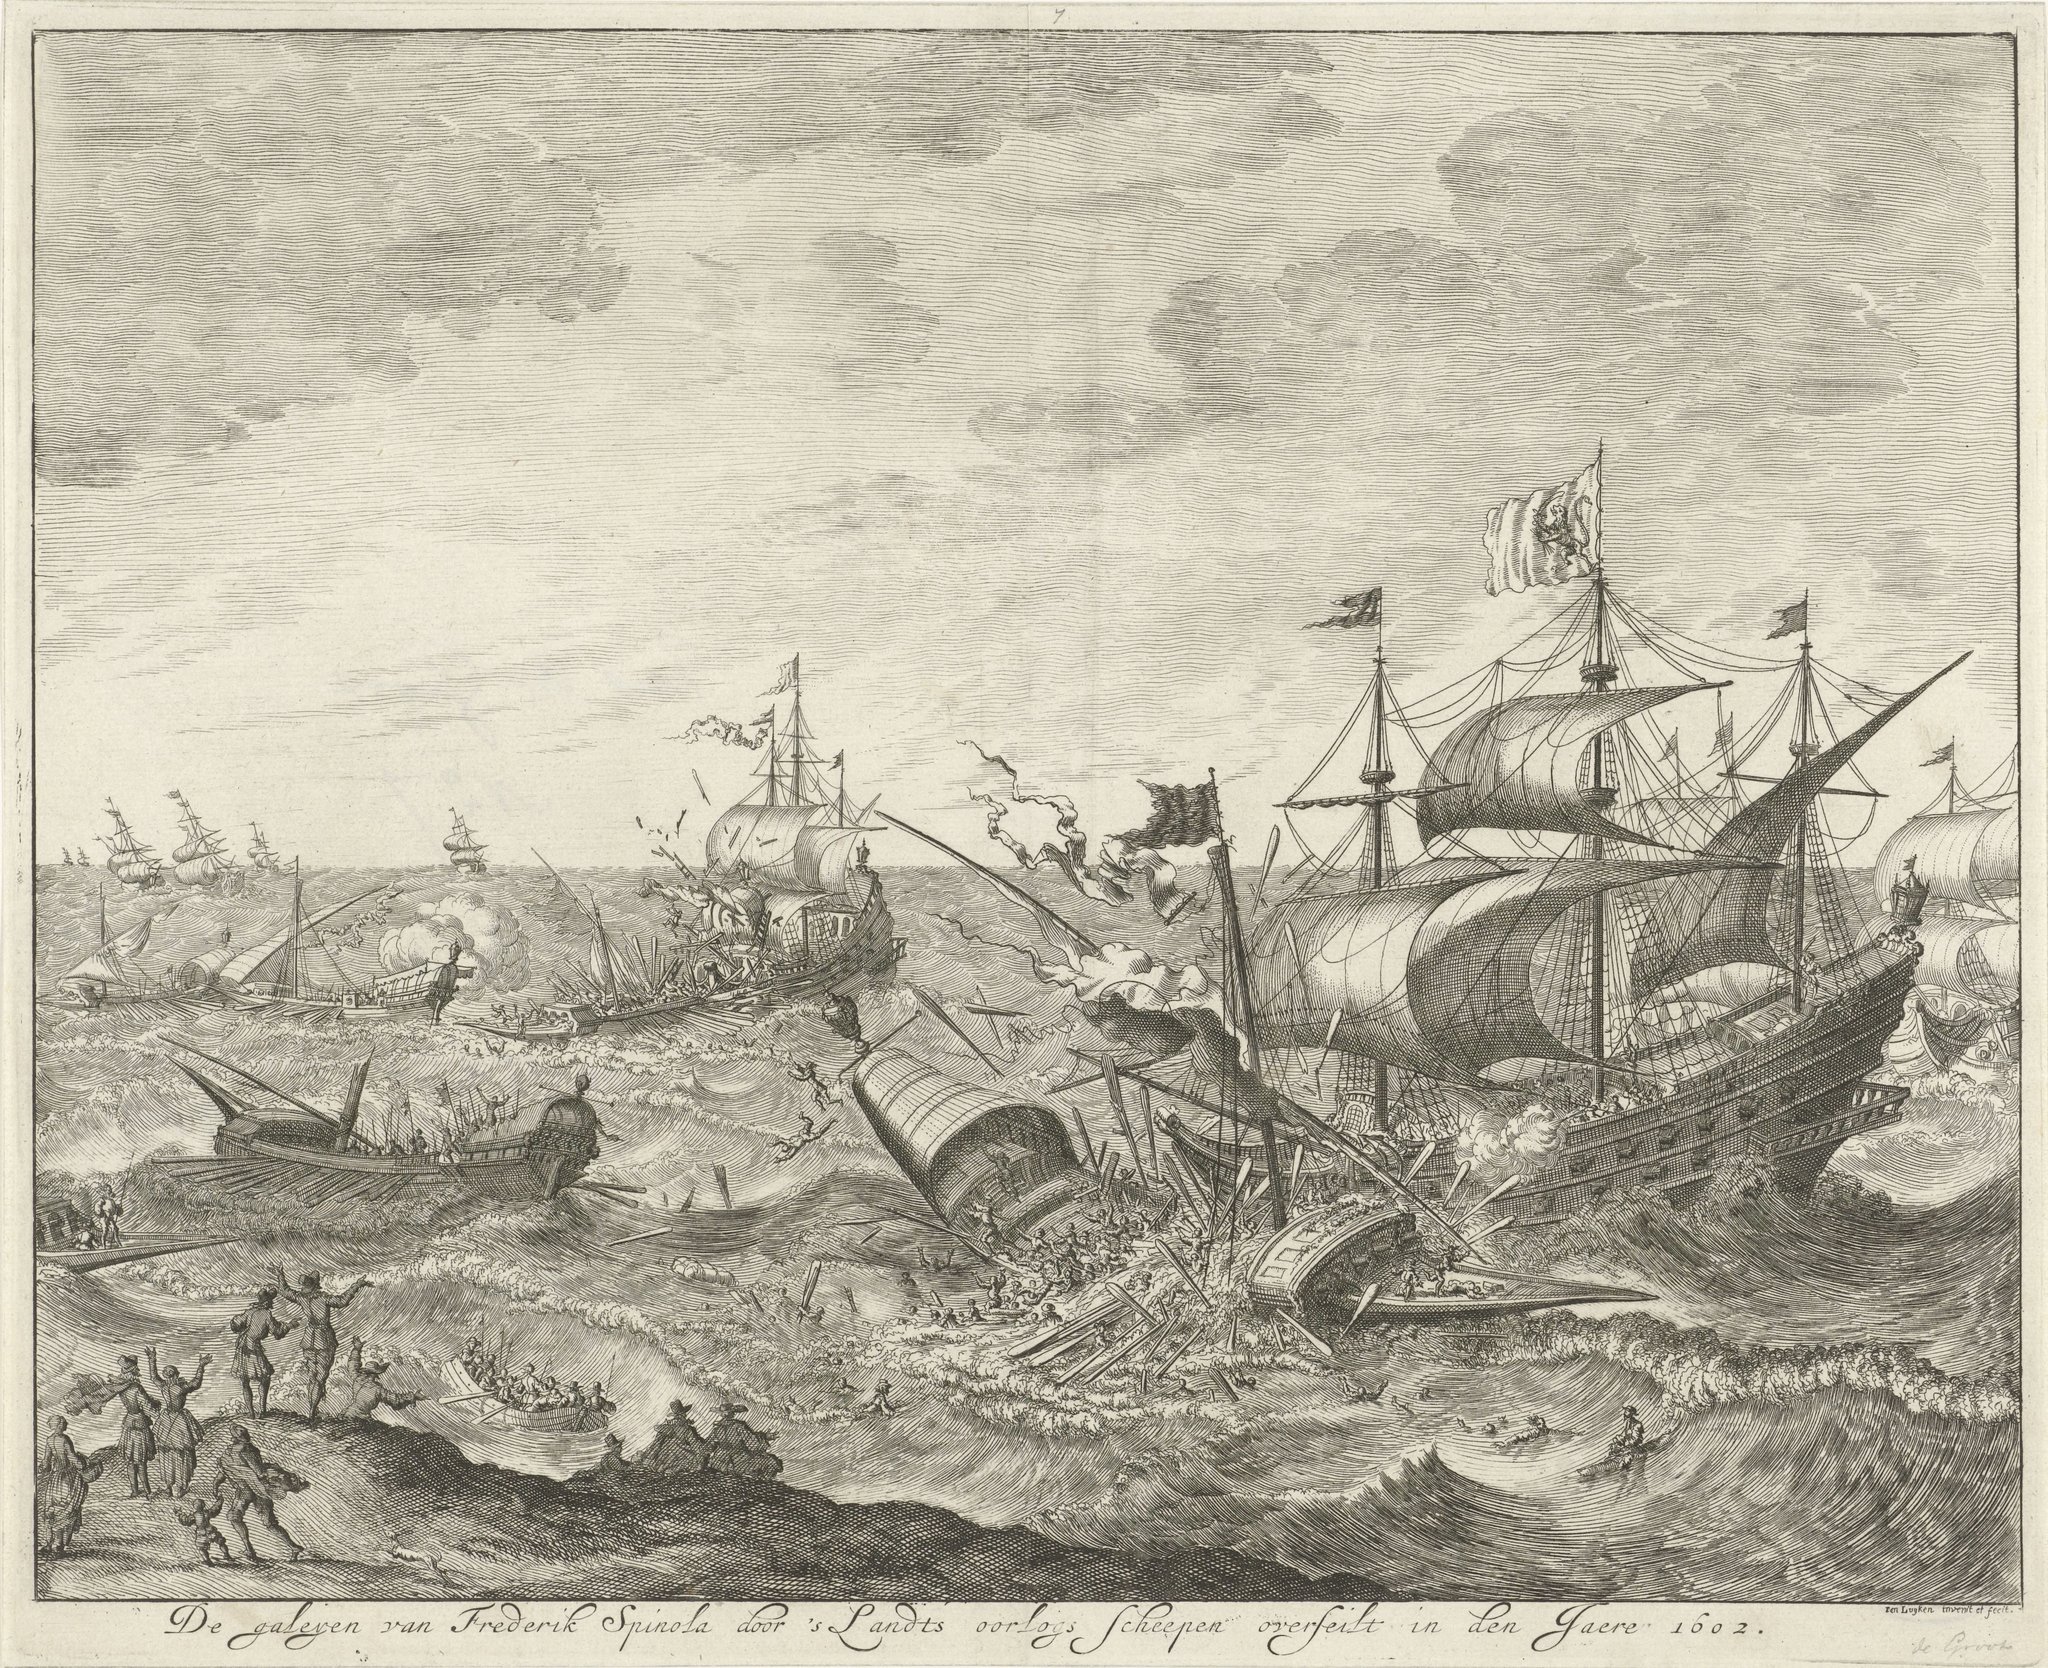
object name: print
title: De galeyen van Frederik Spinola door 's Landts oorlogs scheepen overseilt in den Jaere 1602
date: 1681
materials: paper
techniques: etching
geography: amsterdam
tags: battle (+ naval force), warfare; military affairs (+ oared ships, e.g.: galley), trireme, galley, english channel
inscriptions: collector's mark: Lugt 2228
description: De vernietiging van de Spaanse galeien in het Kanaal voor de Vlaamse kust door de Staatse vloot onder vice-admiraal Jacob van Duivenvoorde, heer van Obdam, 3 oktober 1602. De zeeslag door toeschouwers gade geslagen vanaf de kust.